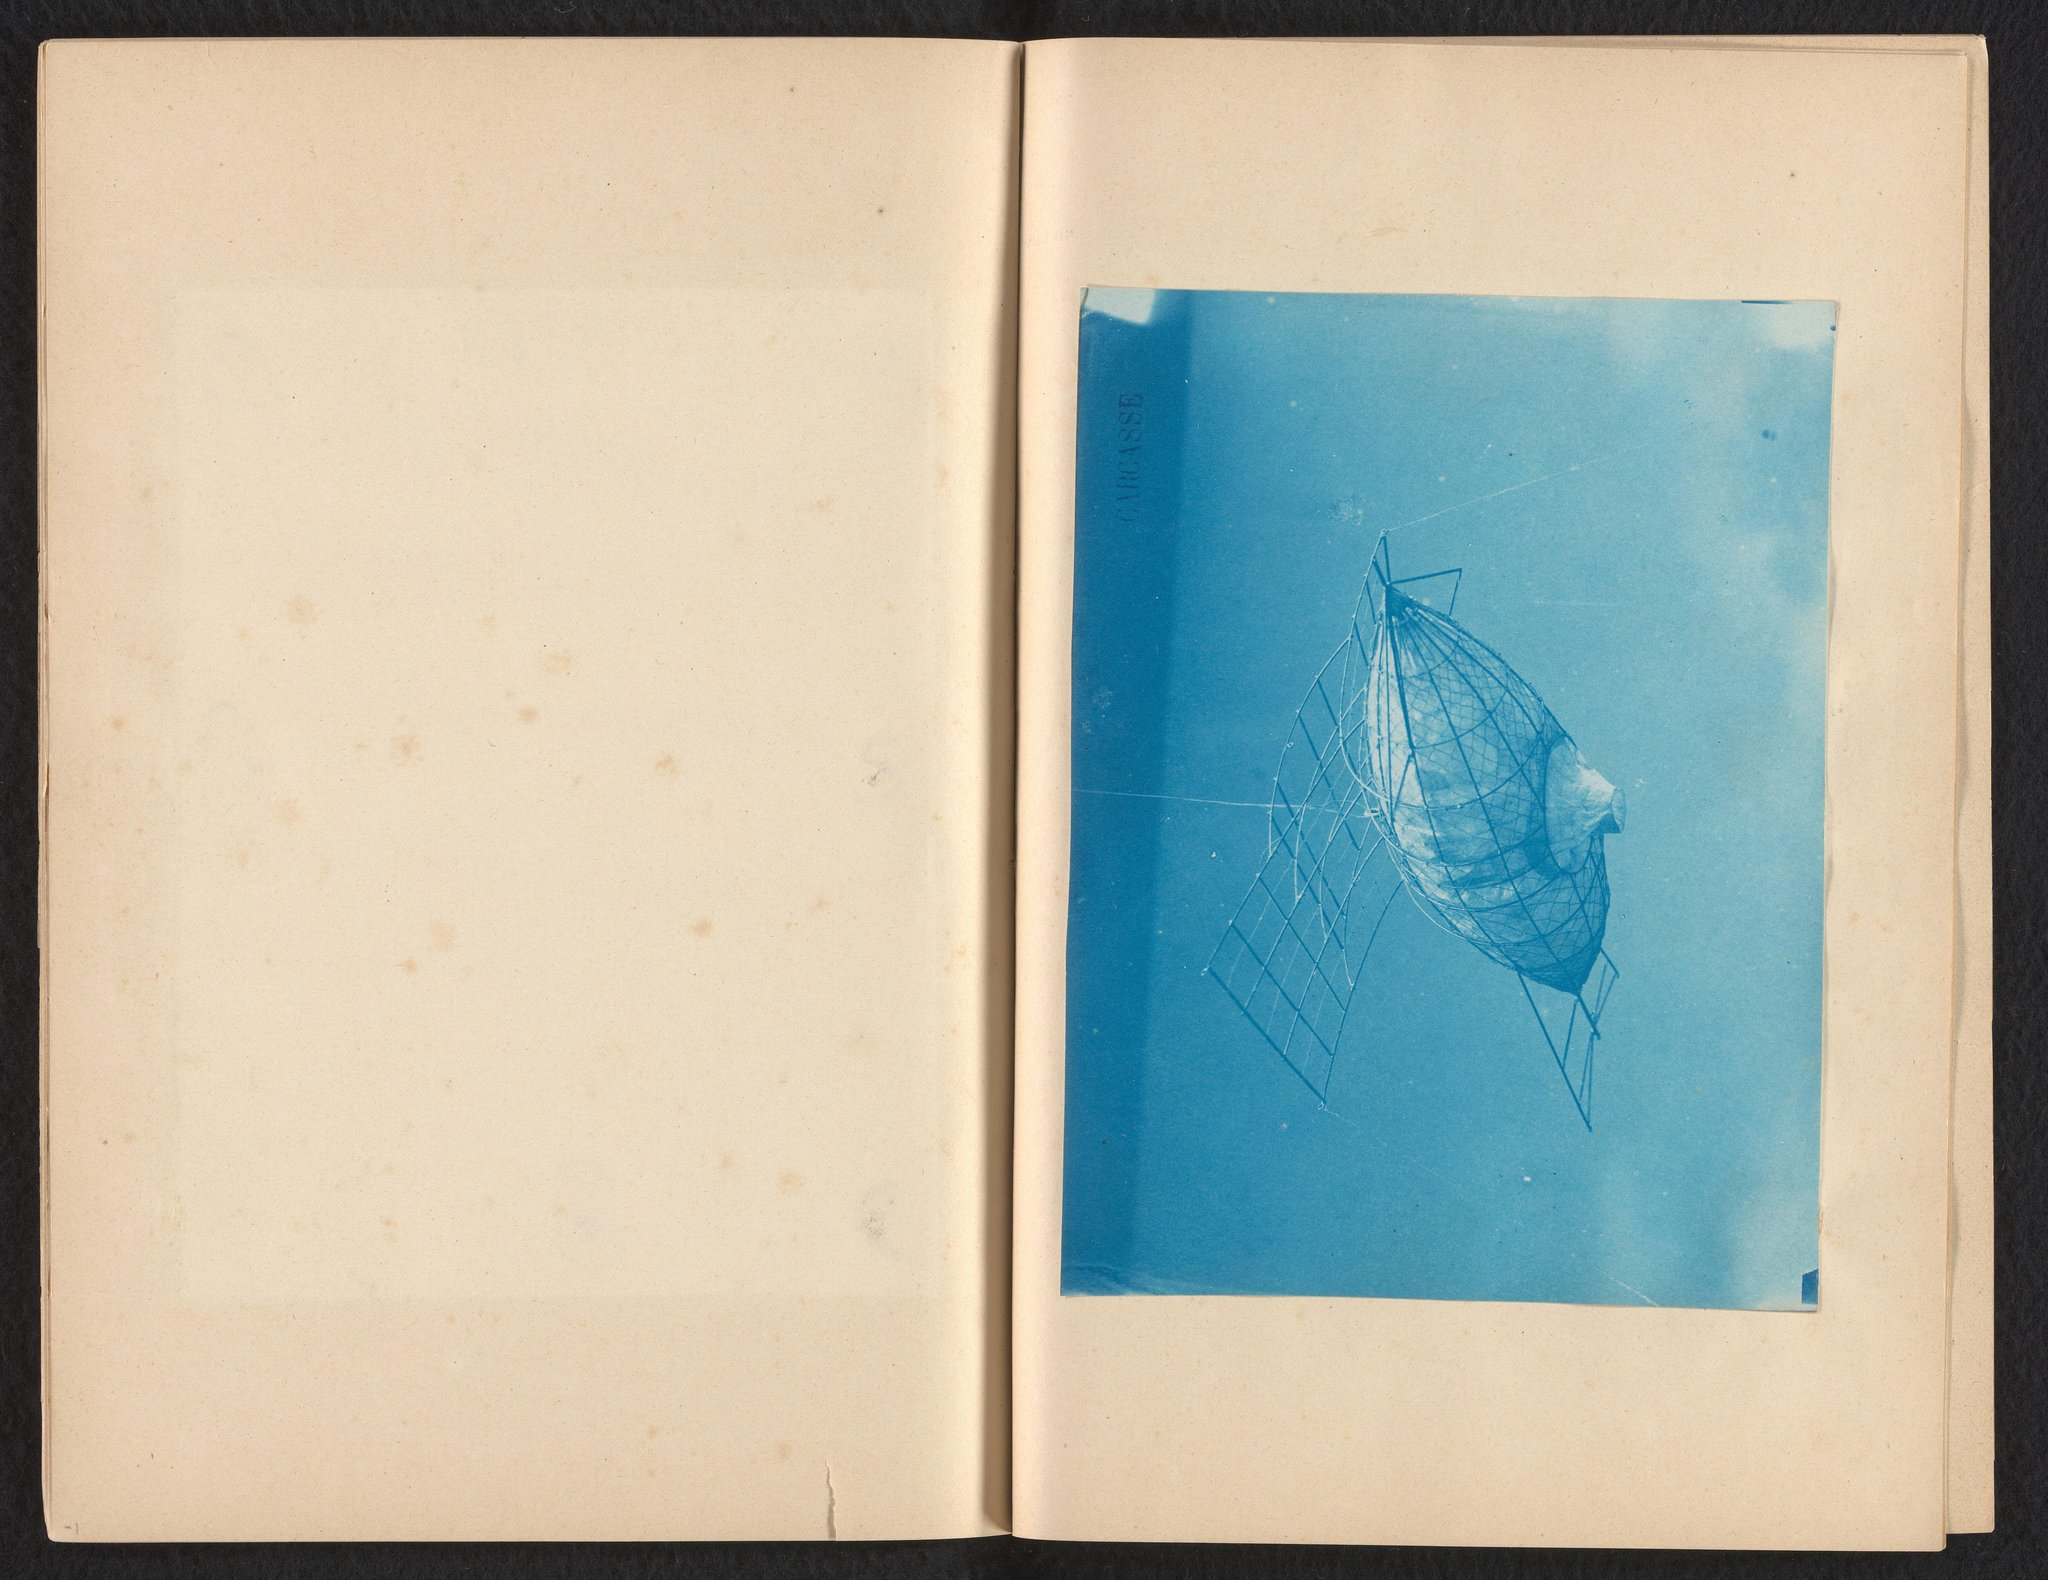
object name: photograph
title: Geraamte van het luchtschip de 'Avisol' van Arsène Olivier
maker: arsène olivier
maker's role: archeoloog, civiel ingenieur, uitvinder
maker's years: 1823-1895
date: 1884-1889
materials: paper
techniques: cyanotype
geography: france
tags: airborne traffic, aviation, 46c35 airship, zeppelin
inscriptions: inscription: ‘CARCASSE’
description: Foto op vierde ongenummerde pagina na pagina 25.